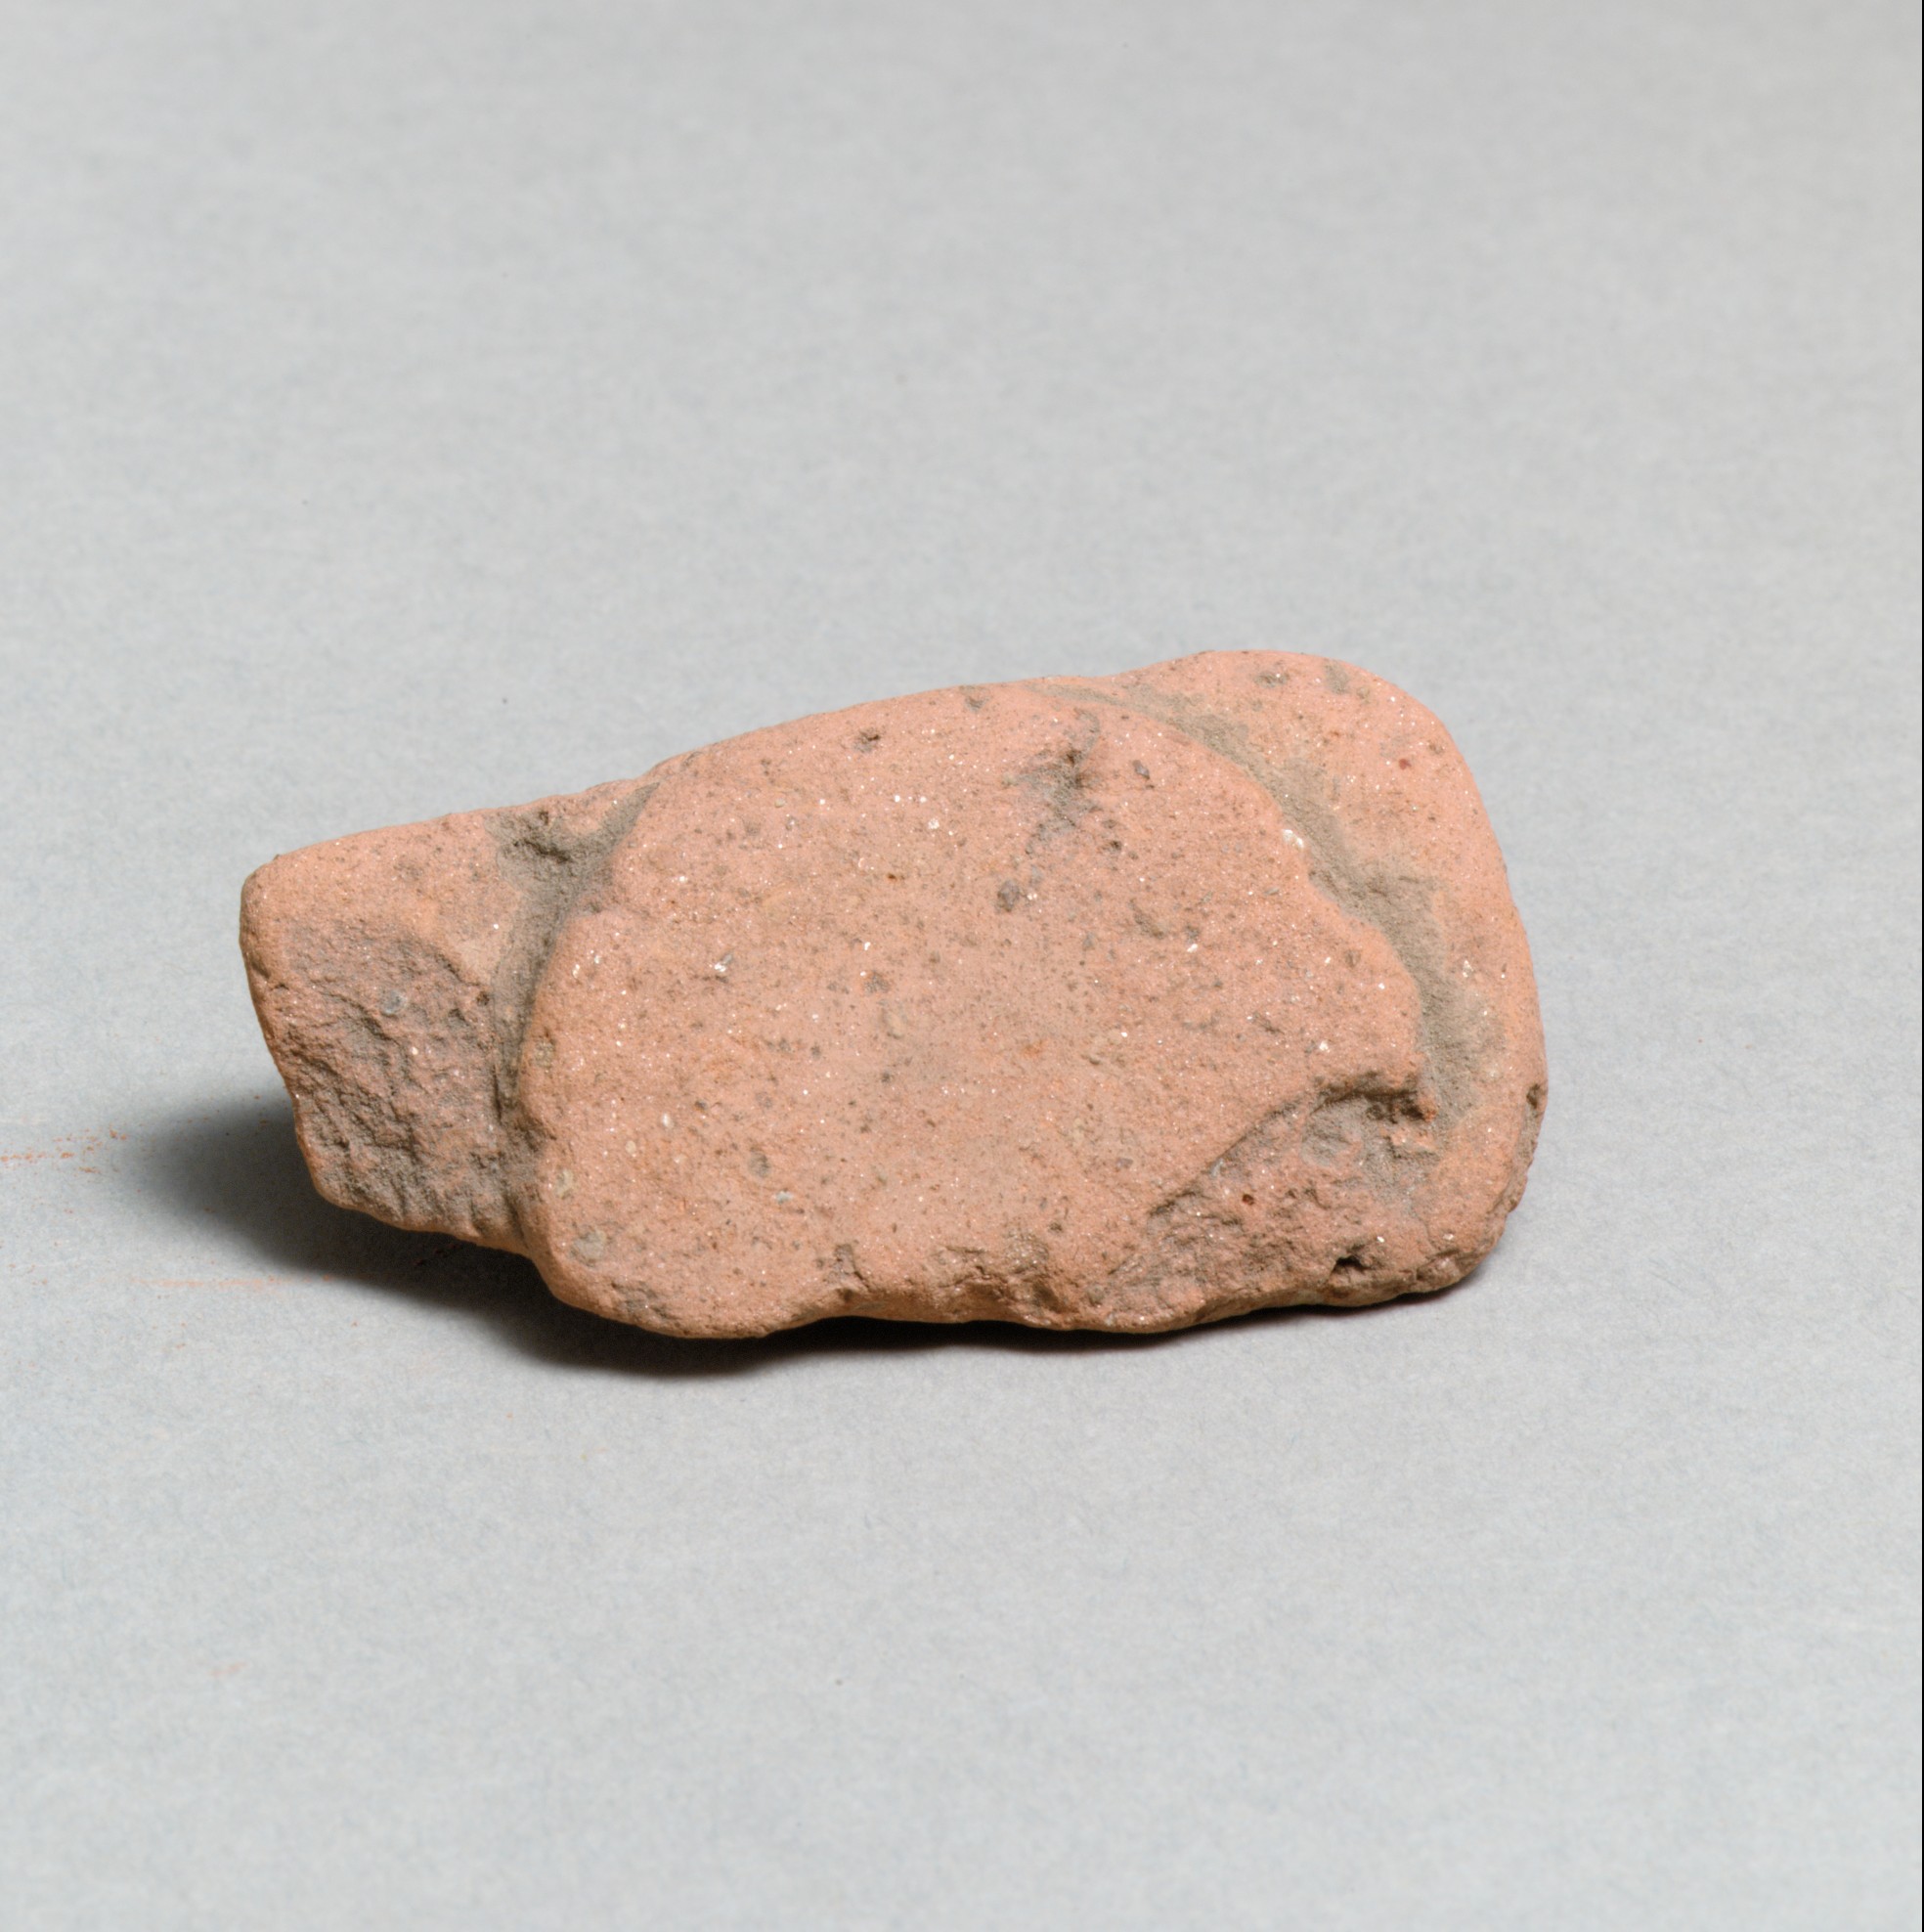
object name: vase fragment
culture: greek, attic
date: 700-601 BCE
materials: terracotta